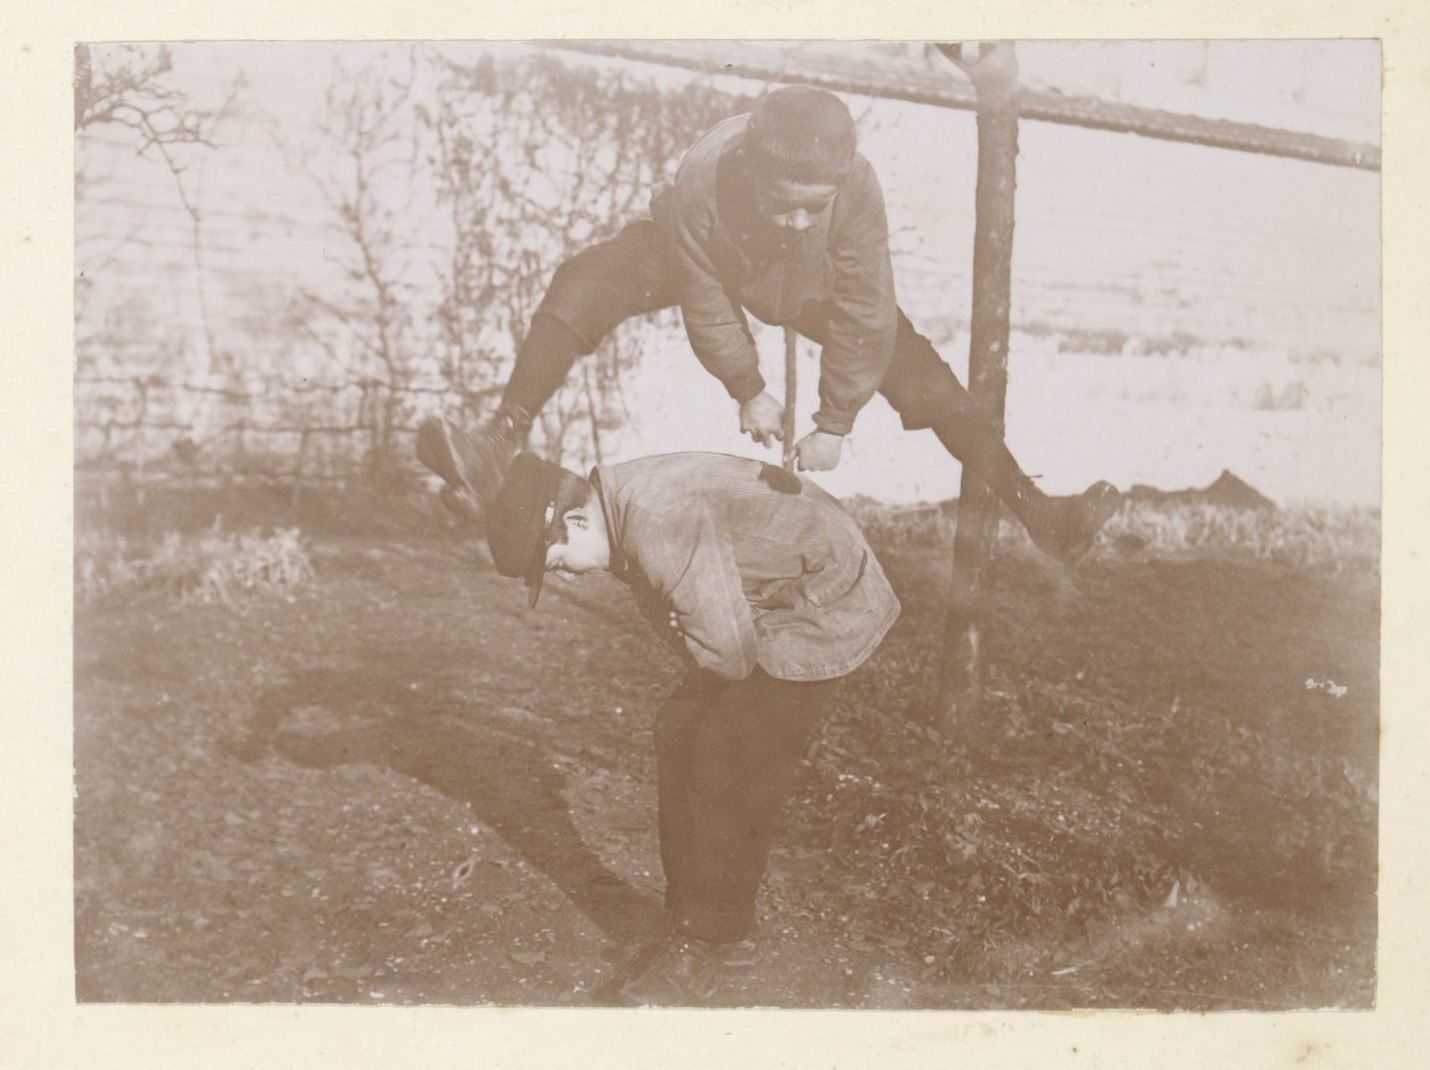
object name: photograph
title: Franse jongens spelen 'haasje over' (bokspringen)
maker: Anonymous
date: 1900-1910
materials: paper, photographic support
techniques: daylight paper print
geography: france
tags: leap-frog and variants, child, france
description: Onderdeel van Fotoalbum van een Franse amateurfotograaf met opnames van een familie, distilleerderij Delizy & Doistau Fils, het leger en bezienswaardigheden in Frankrijk.